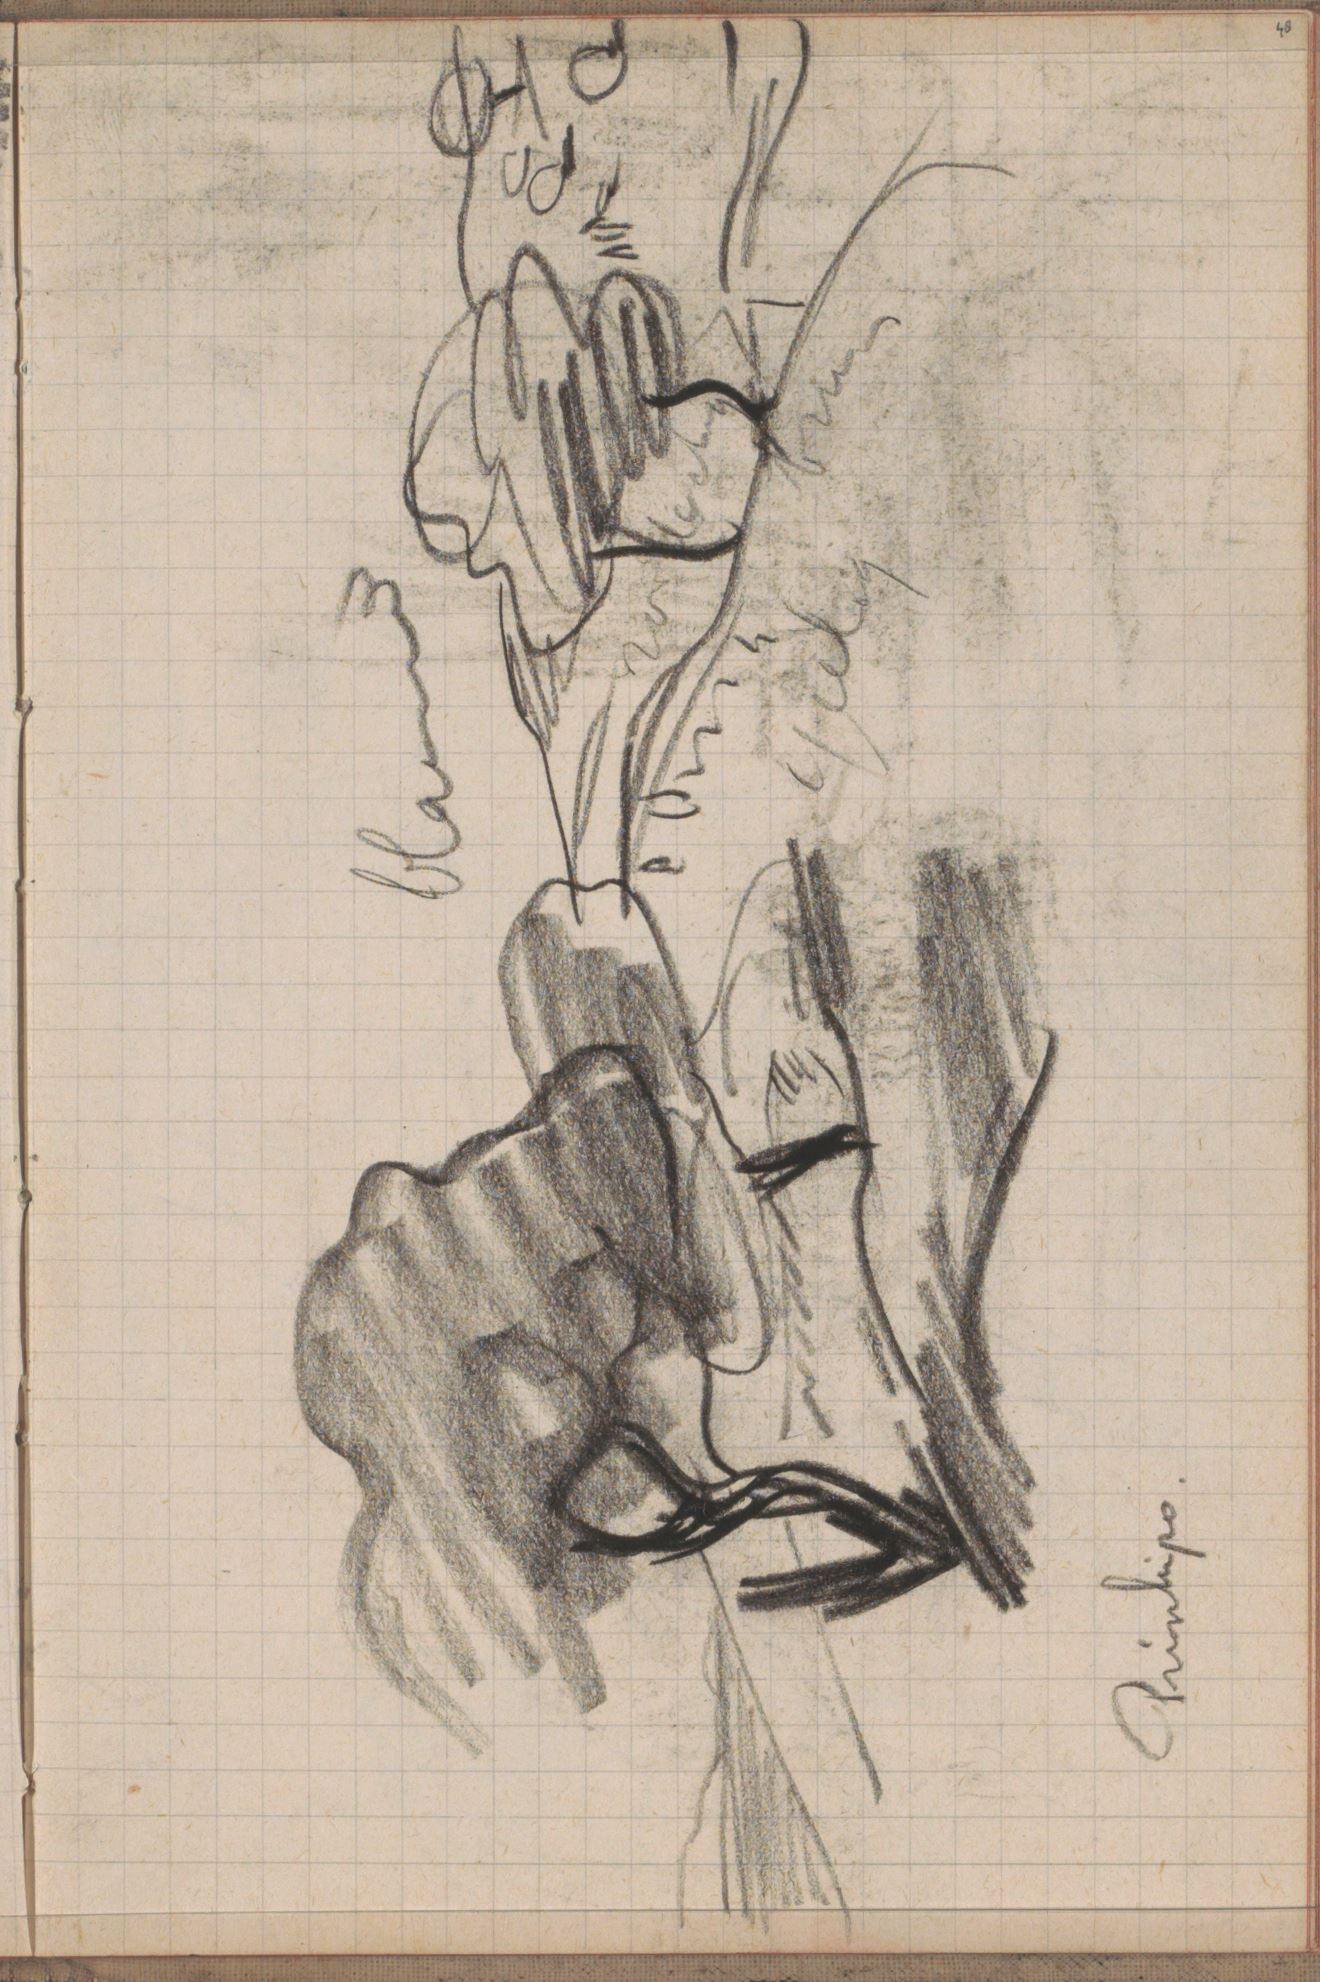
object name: sketchbook leaf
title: Landschap met bomen in Prinkipo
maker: marius bauer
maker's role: draughtsman, print maker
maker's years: 1867-1932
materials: chalk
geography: istanbul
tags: trees, landscapes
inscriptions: annotation: ‘Prinkipo.’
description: Prinkipo is één van de Prinseneilanden in de Zee van Marmara behorend tot de stad Istanbul. Pagina 48 uit een schetsboek met 54 bladen.